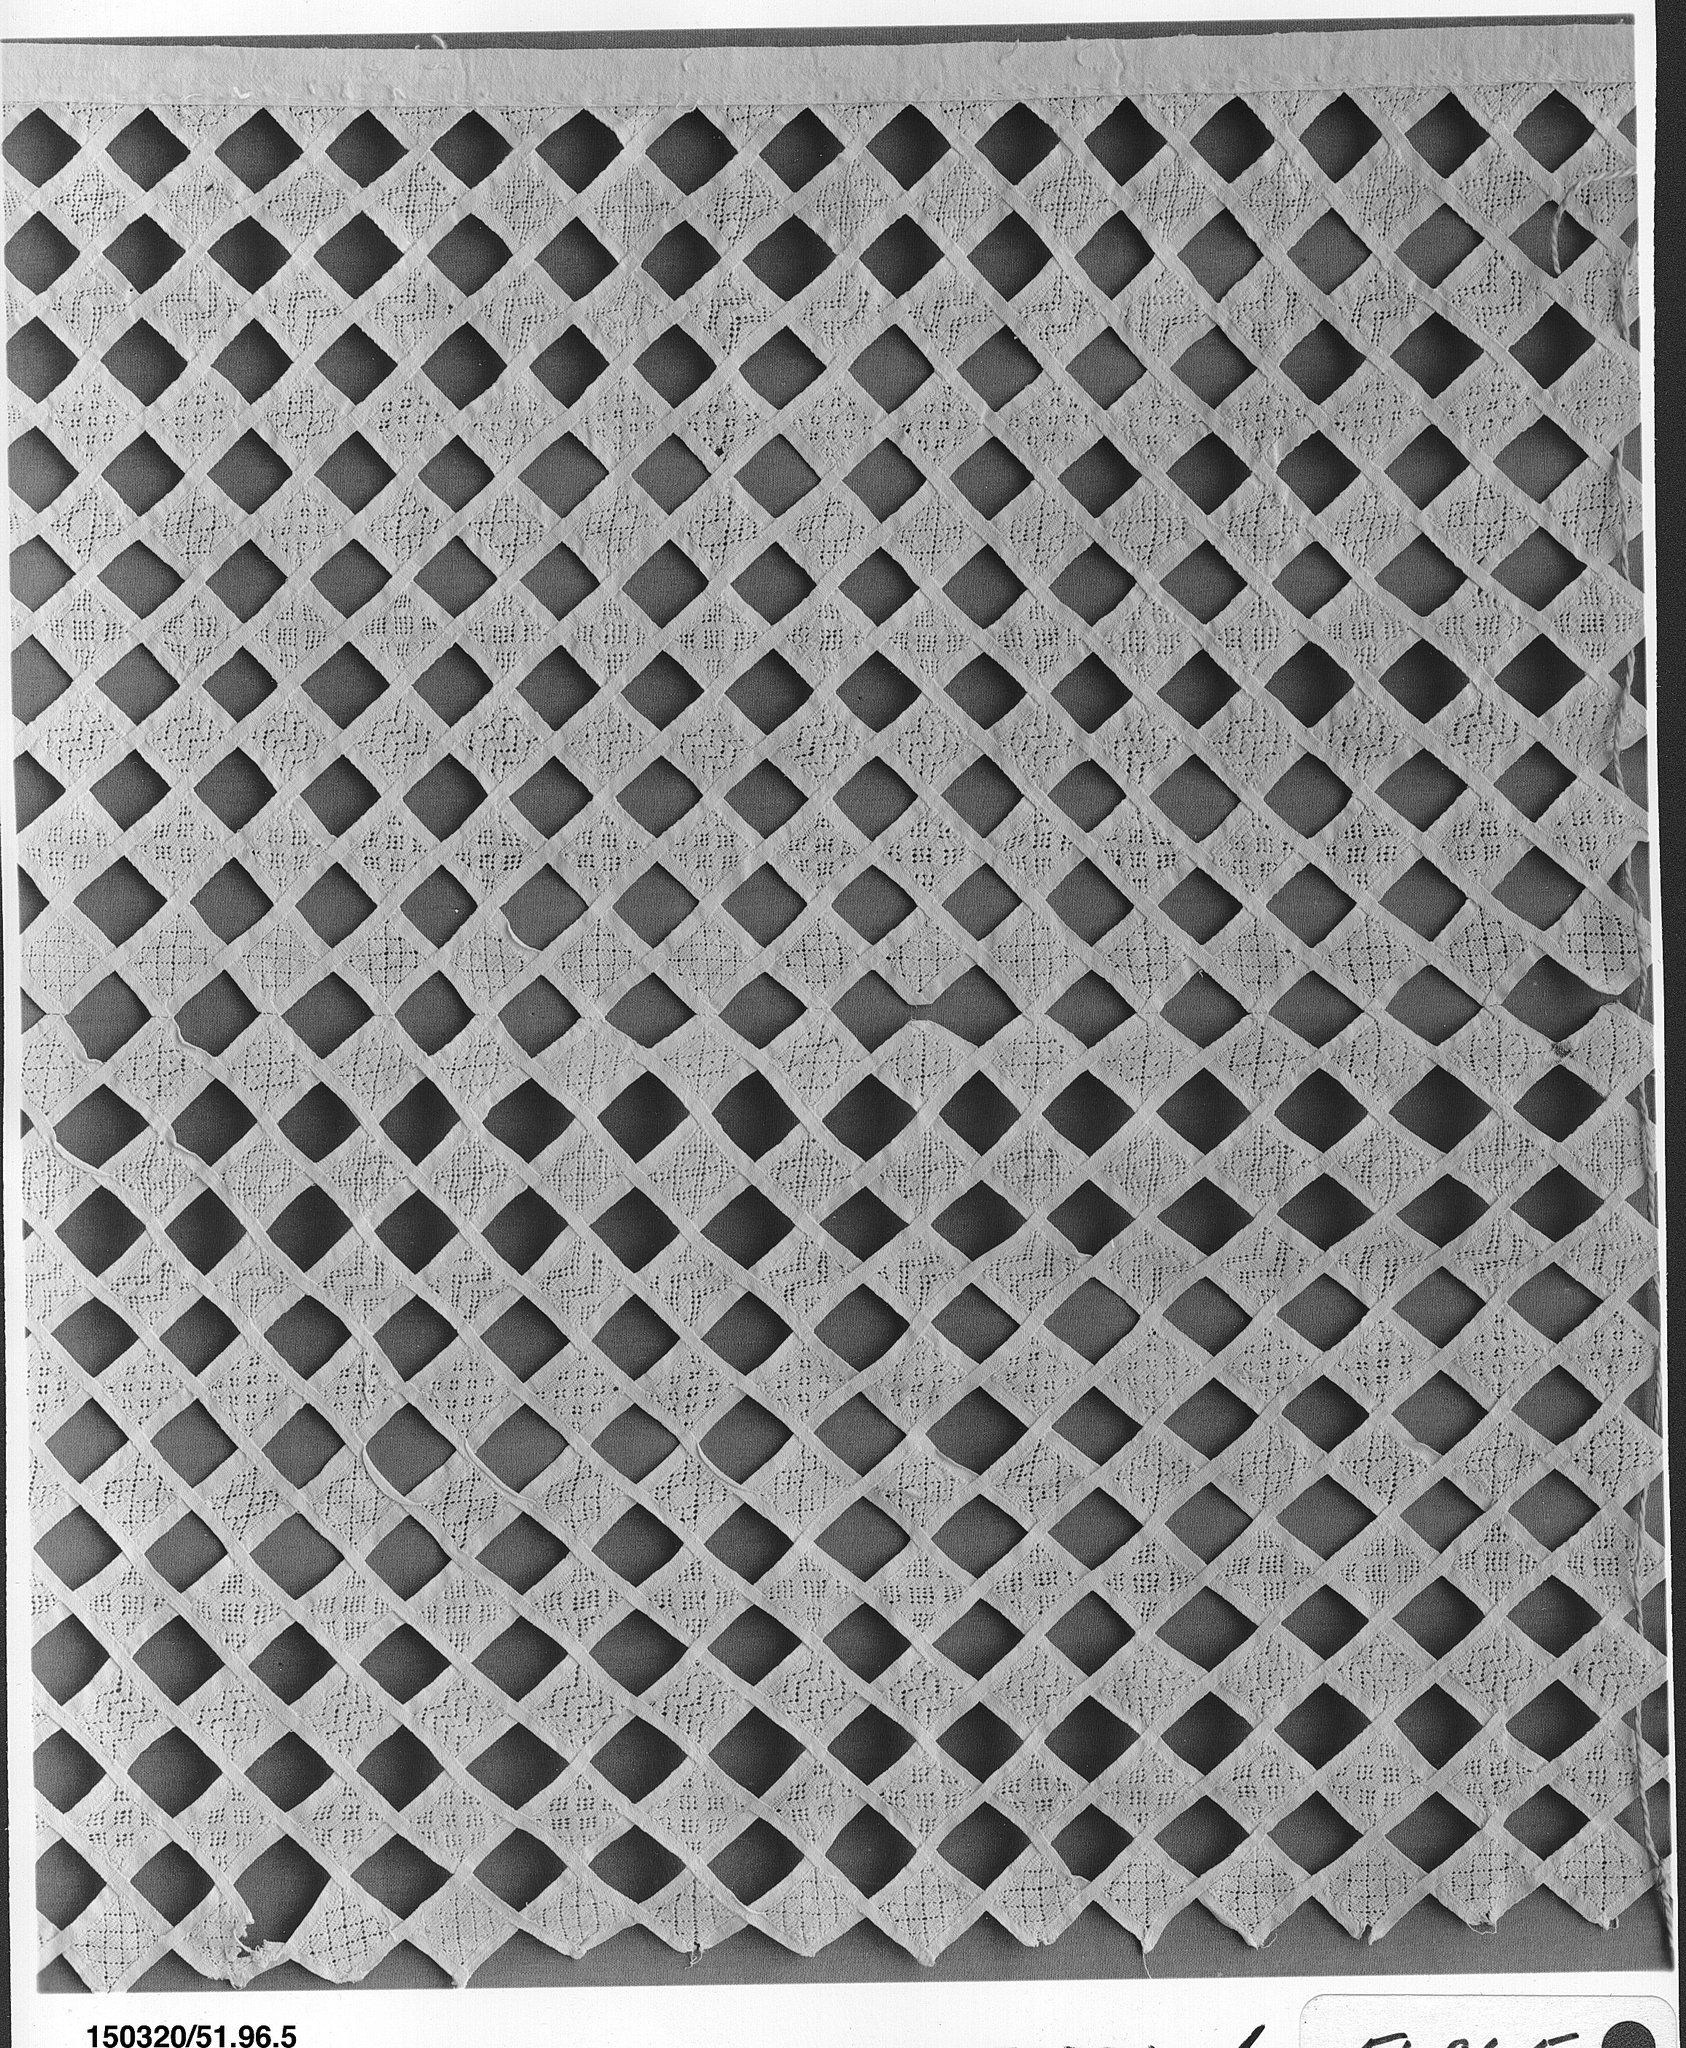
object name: altar frontal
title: Altar frontal (?)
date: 1601-1700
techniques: lace